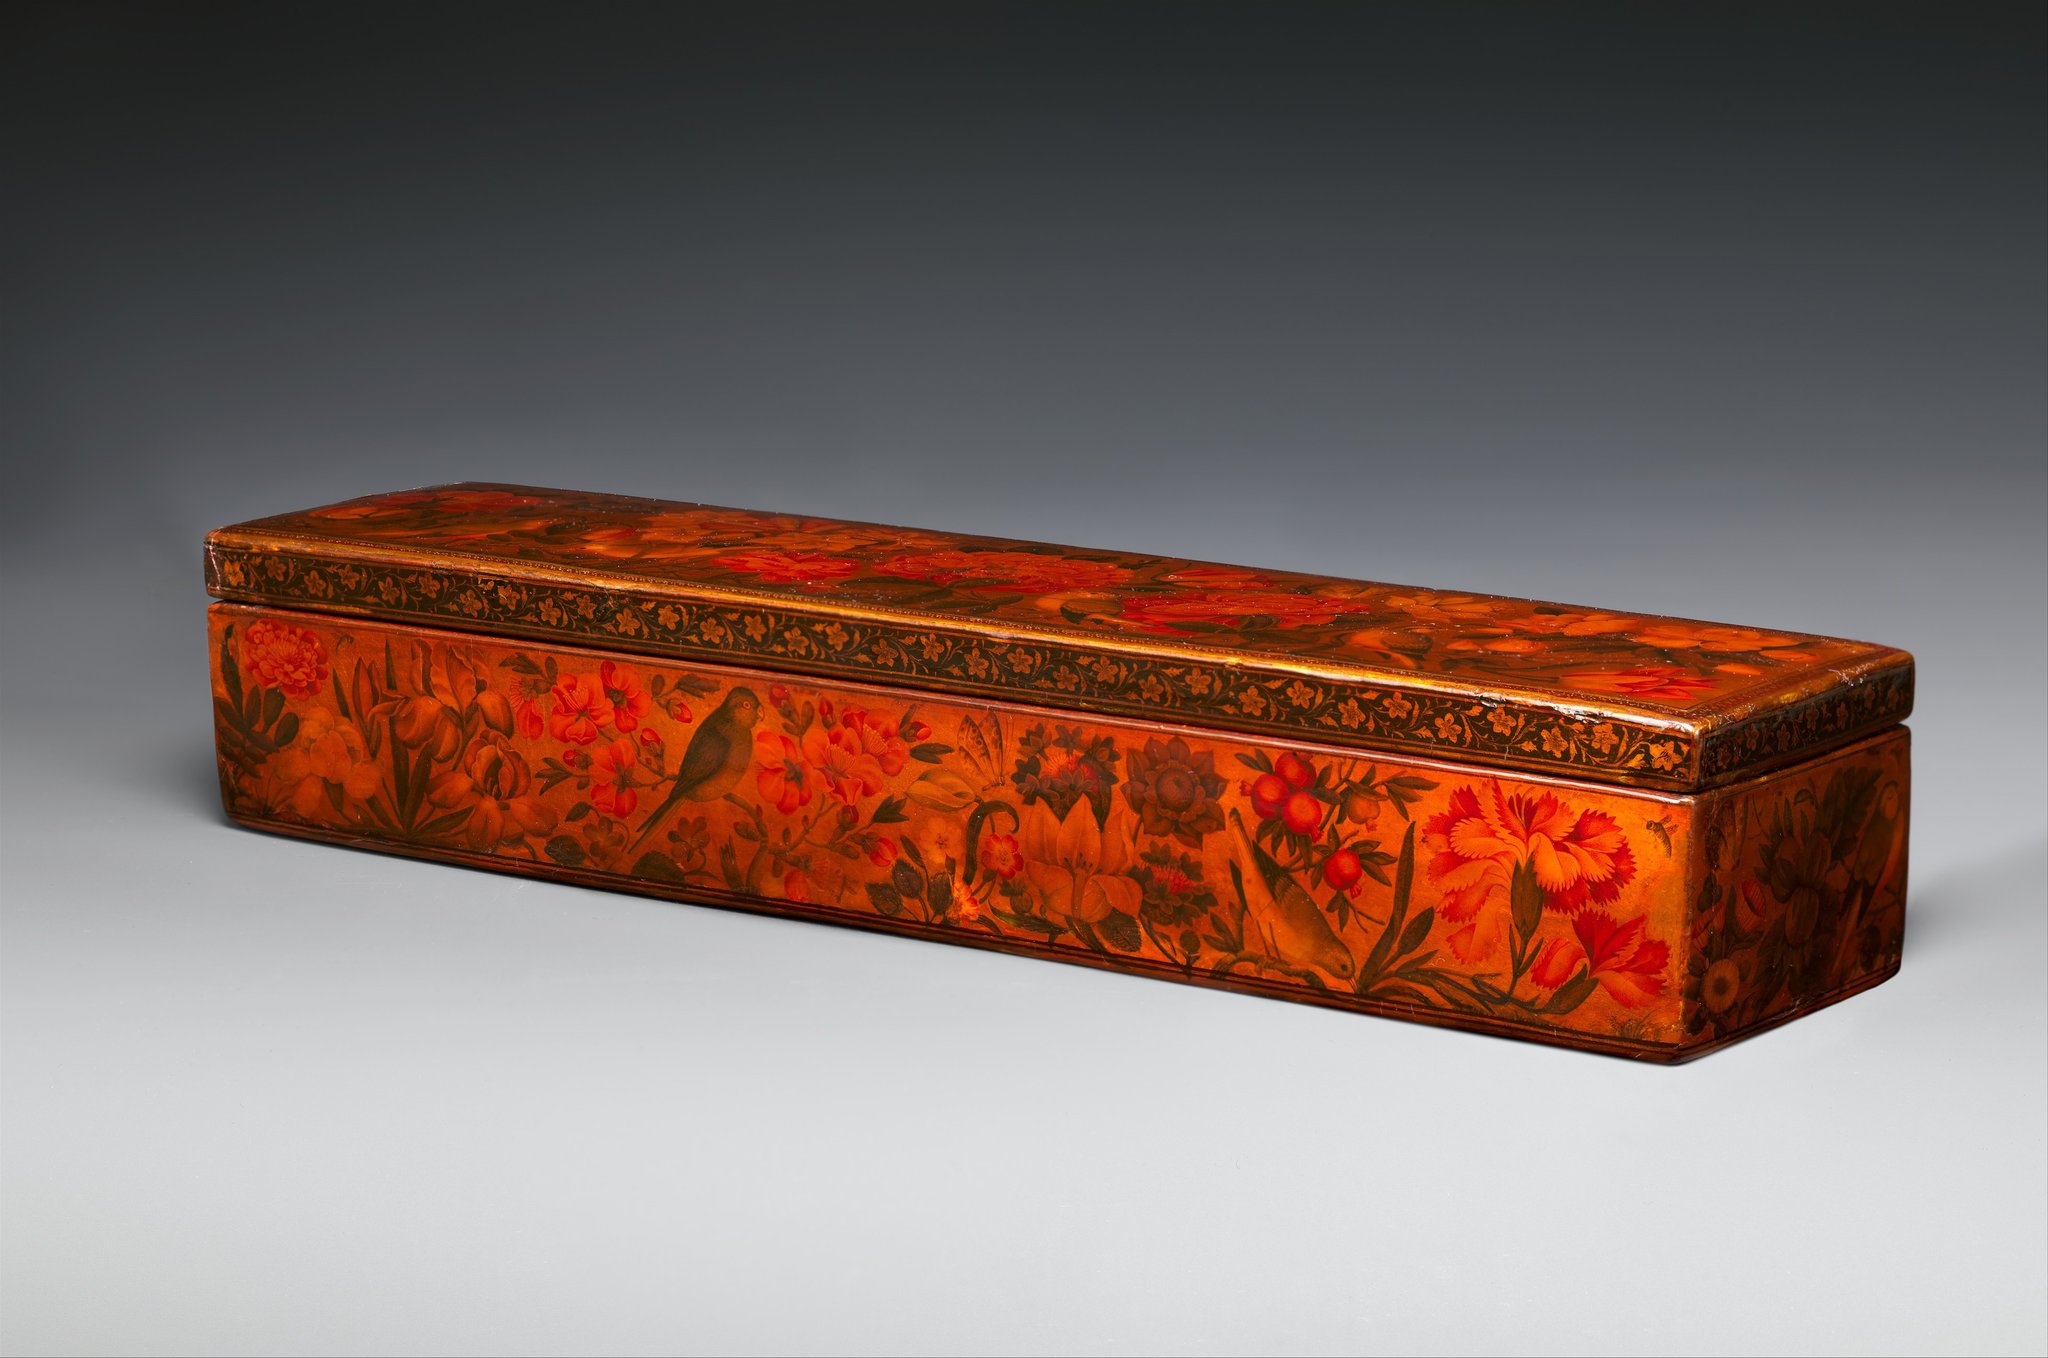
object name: pen box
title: Lacquer Pen Box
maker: muhammad sadiq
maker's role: artist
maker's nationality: iranian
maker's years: 1715-1805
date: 1793-1794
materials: paper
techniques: lacquer, painting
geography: iran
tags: birds,flowers,leaves